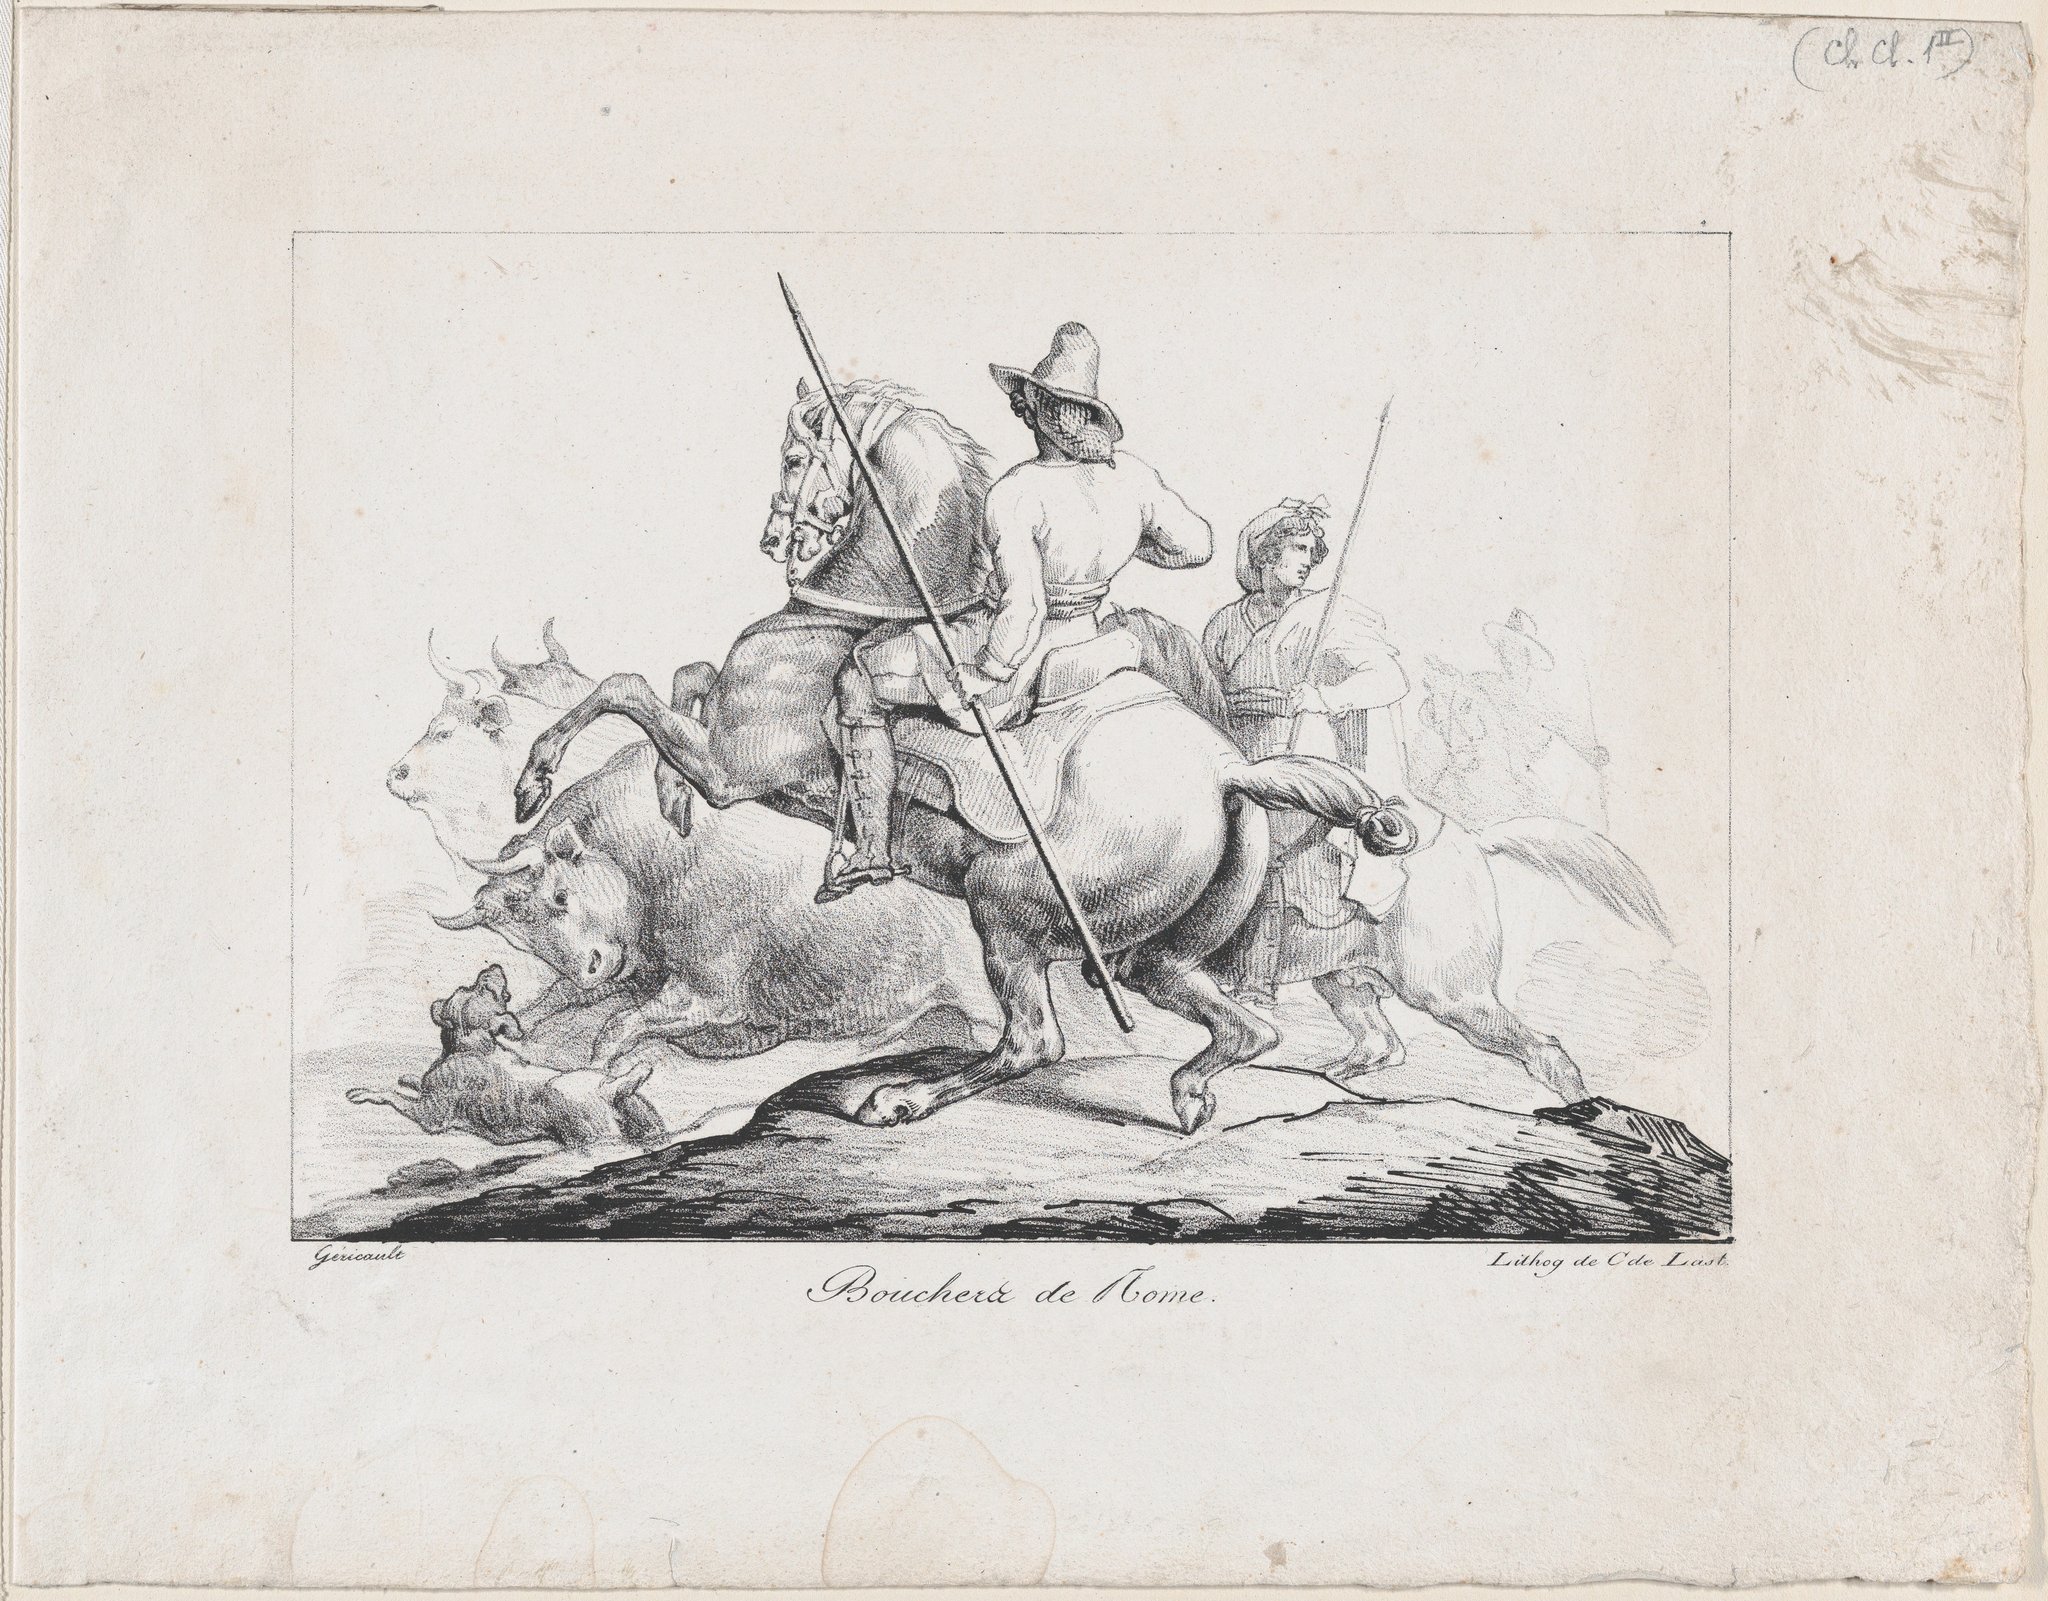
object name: print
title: Bouchers de Rome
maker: jean louis andré théodore géricault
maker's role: artist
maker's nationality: french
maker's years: 1791-1824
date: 1817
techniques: lithograph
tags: spears,men,bulls,dogs,horses